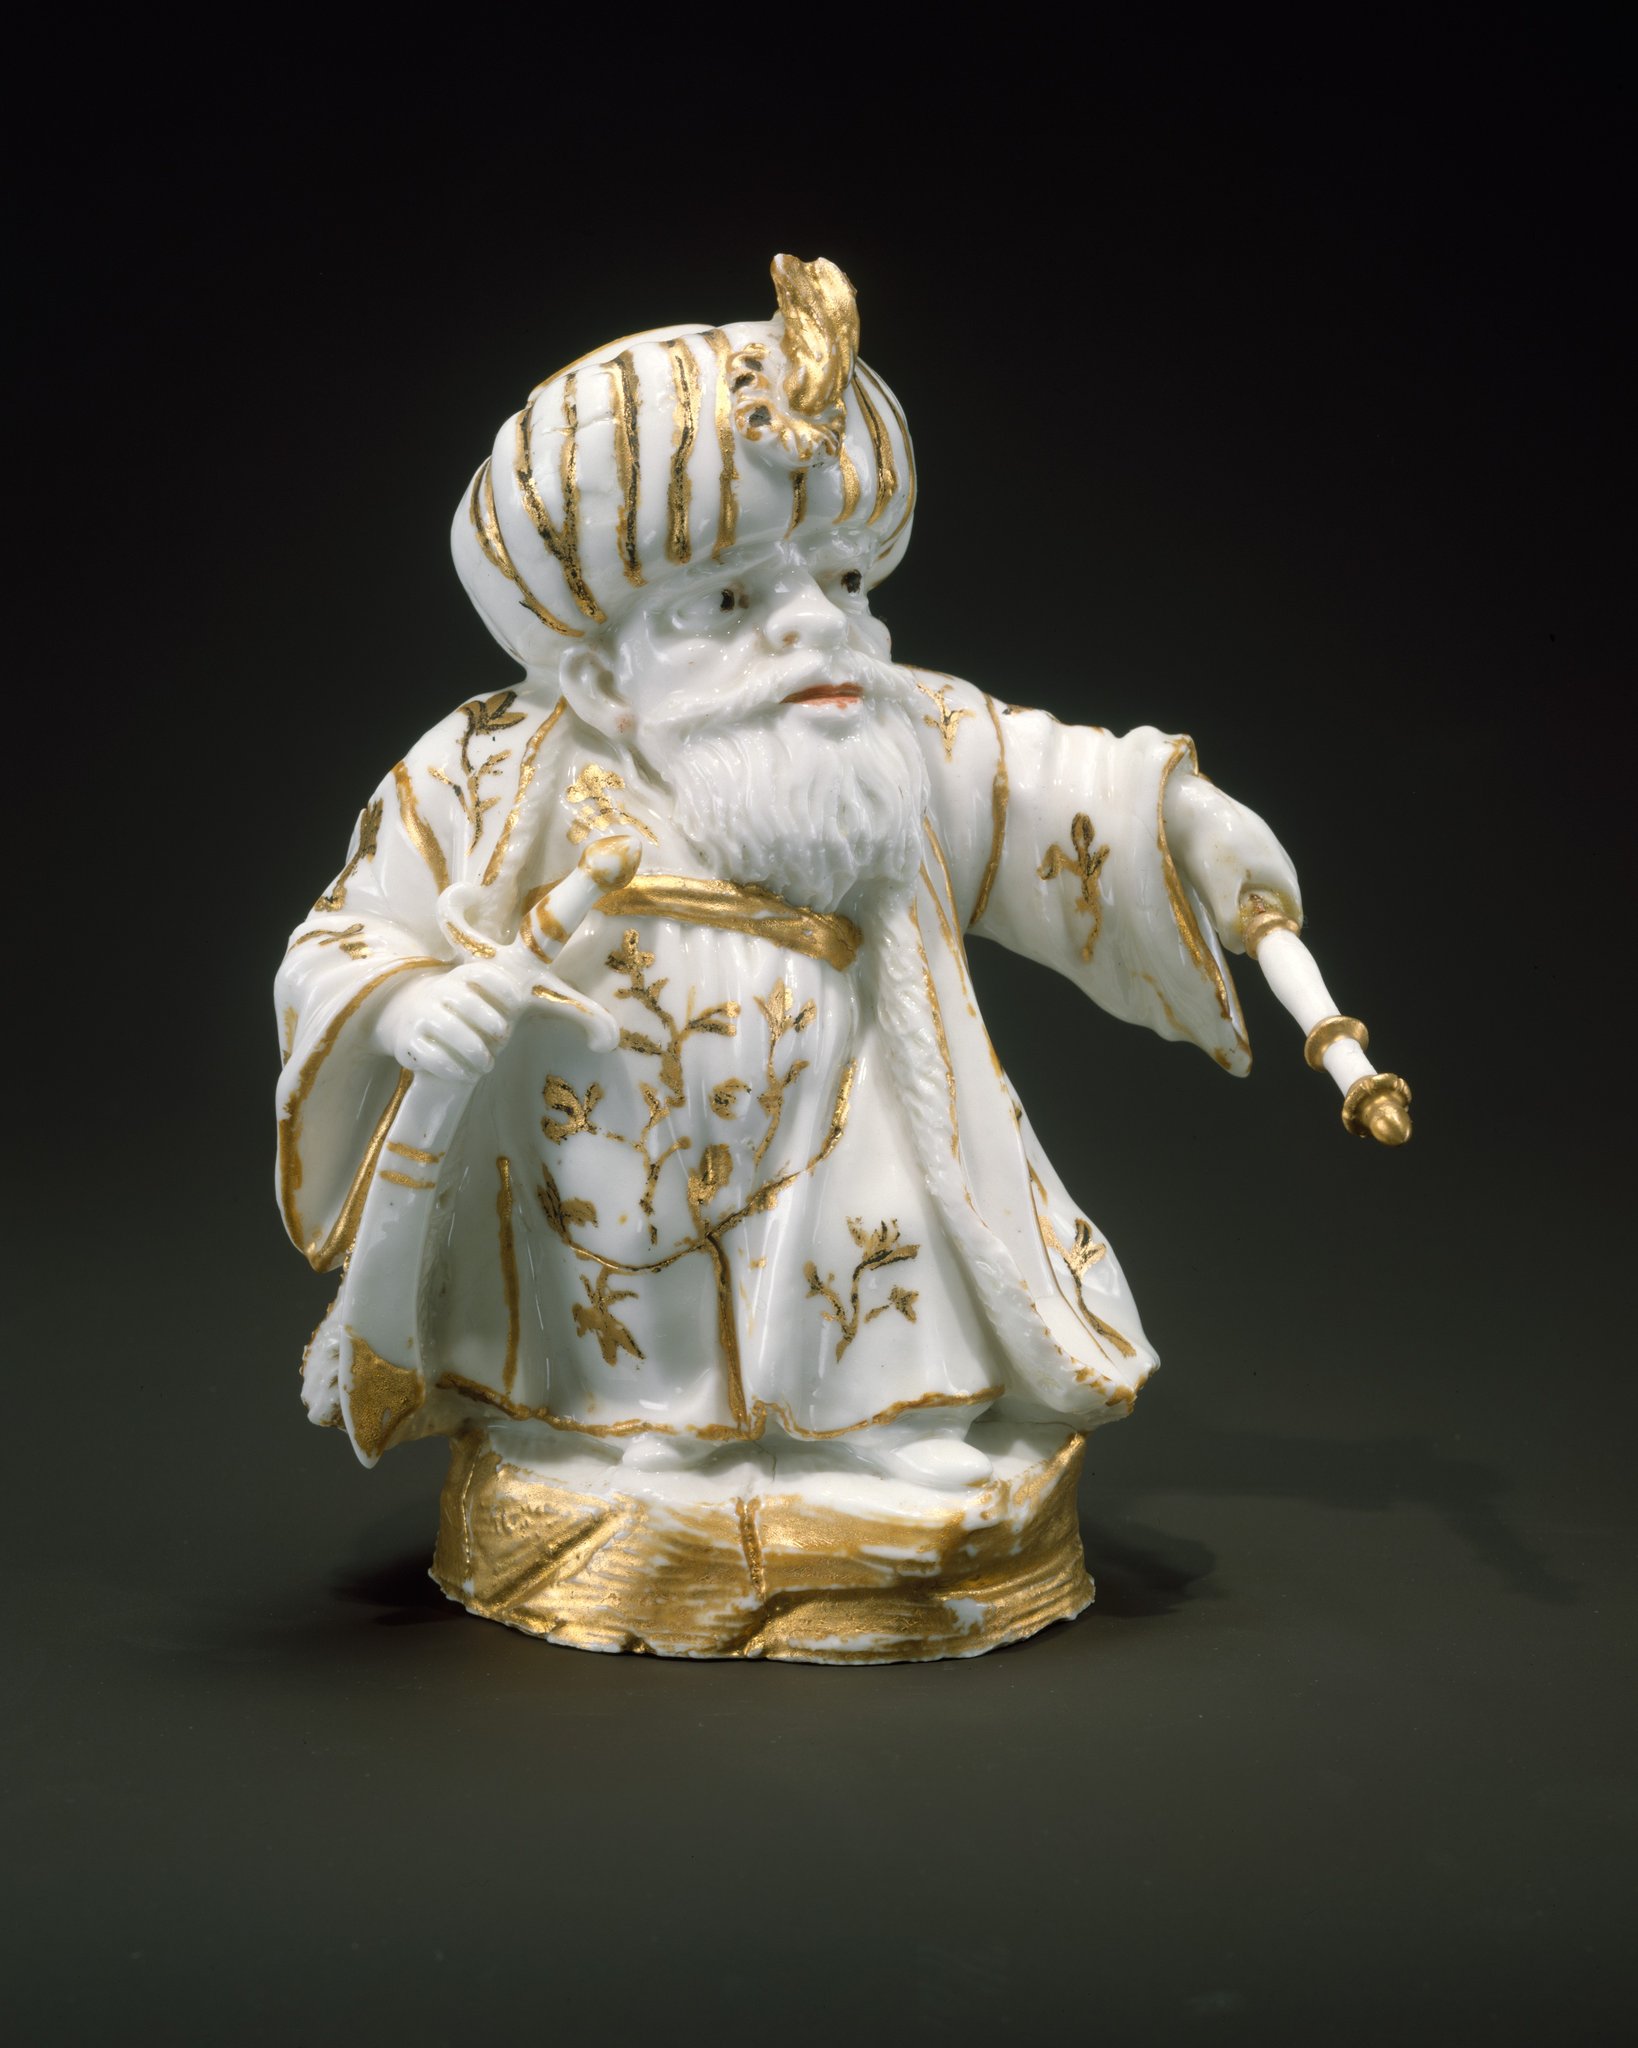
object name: figure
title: Dwarf as a Turkish Pasha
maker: capodimonte porcelain manufactory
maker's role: manufactory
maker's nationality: italian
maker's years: 1740-1759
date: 1745-1750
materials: soft paste porcelain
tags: swords,men